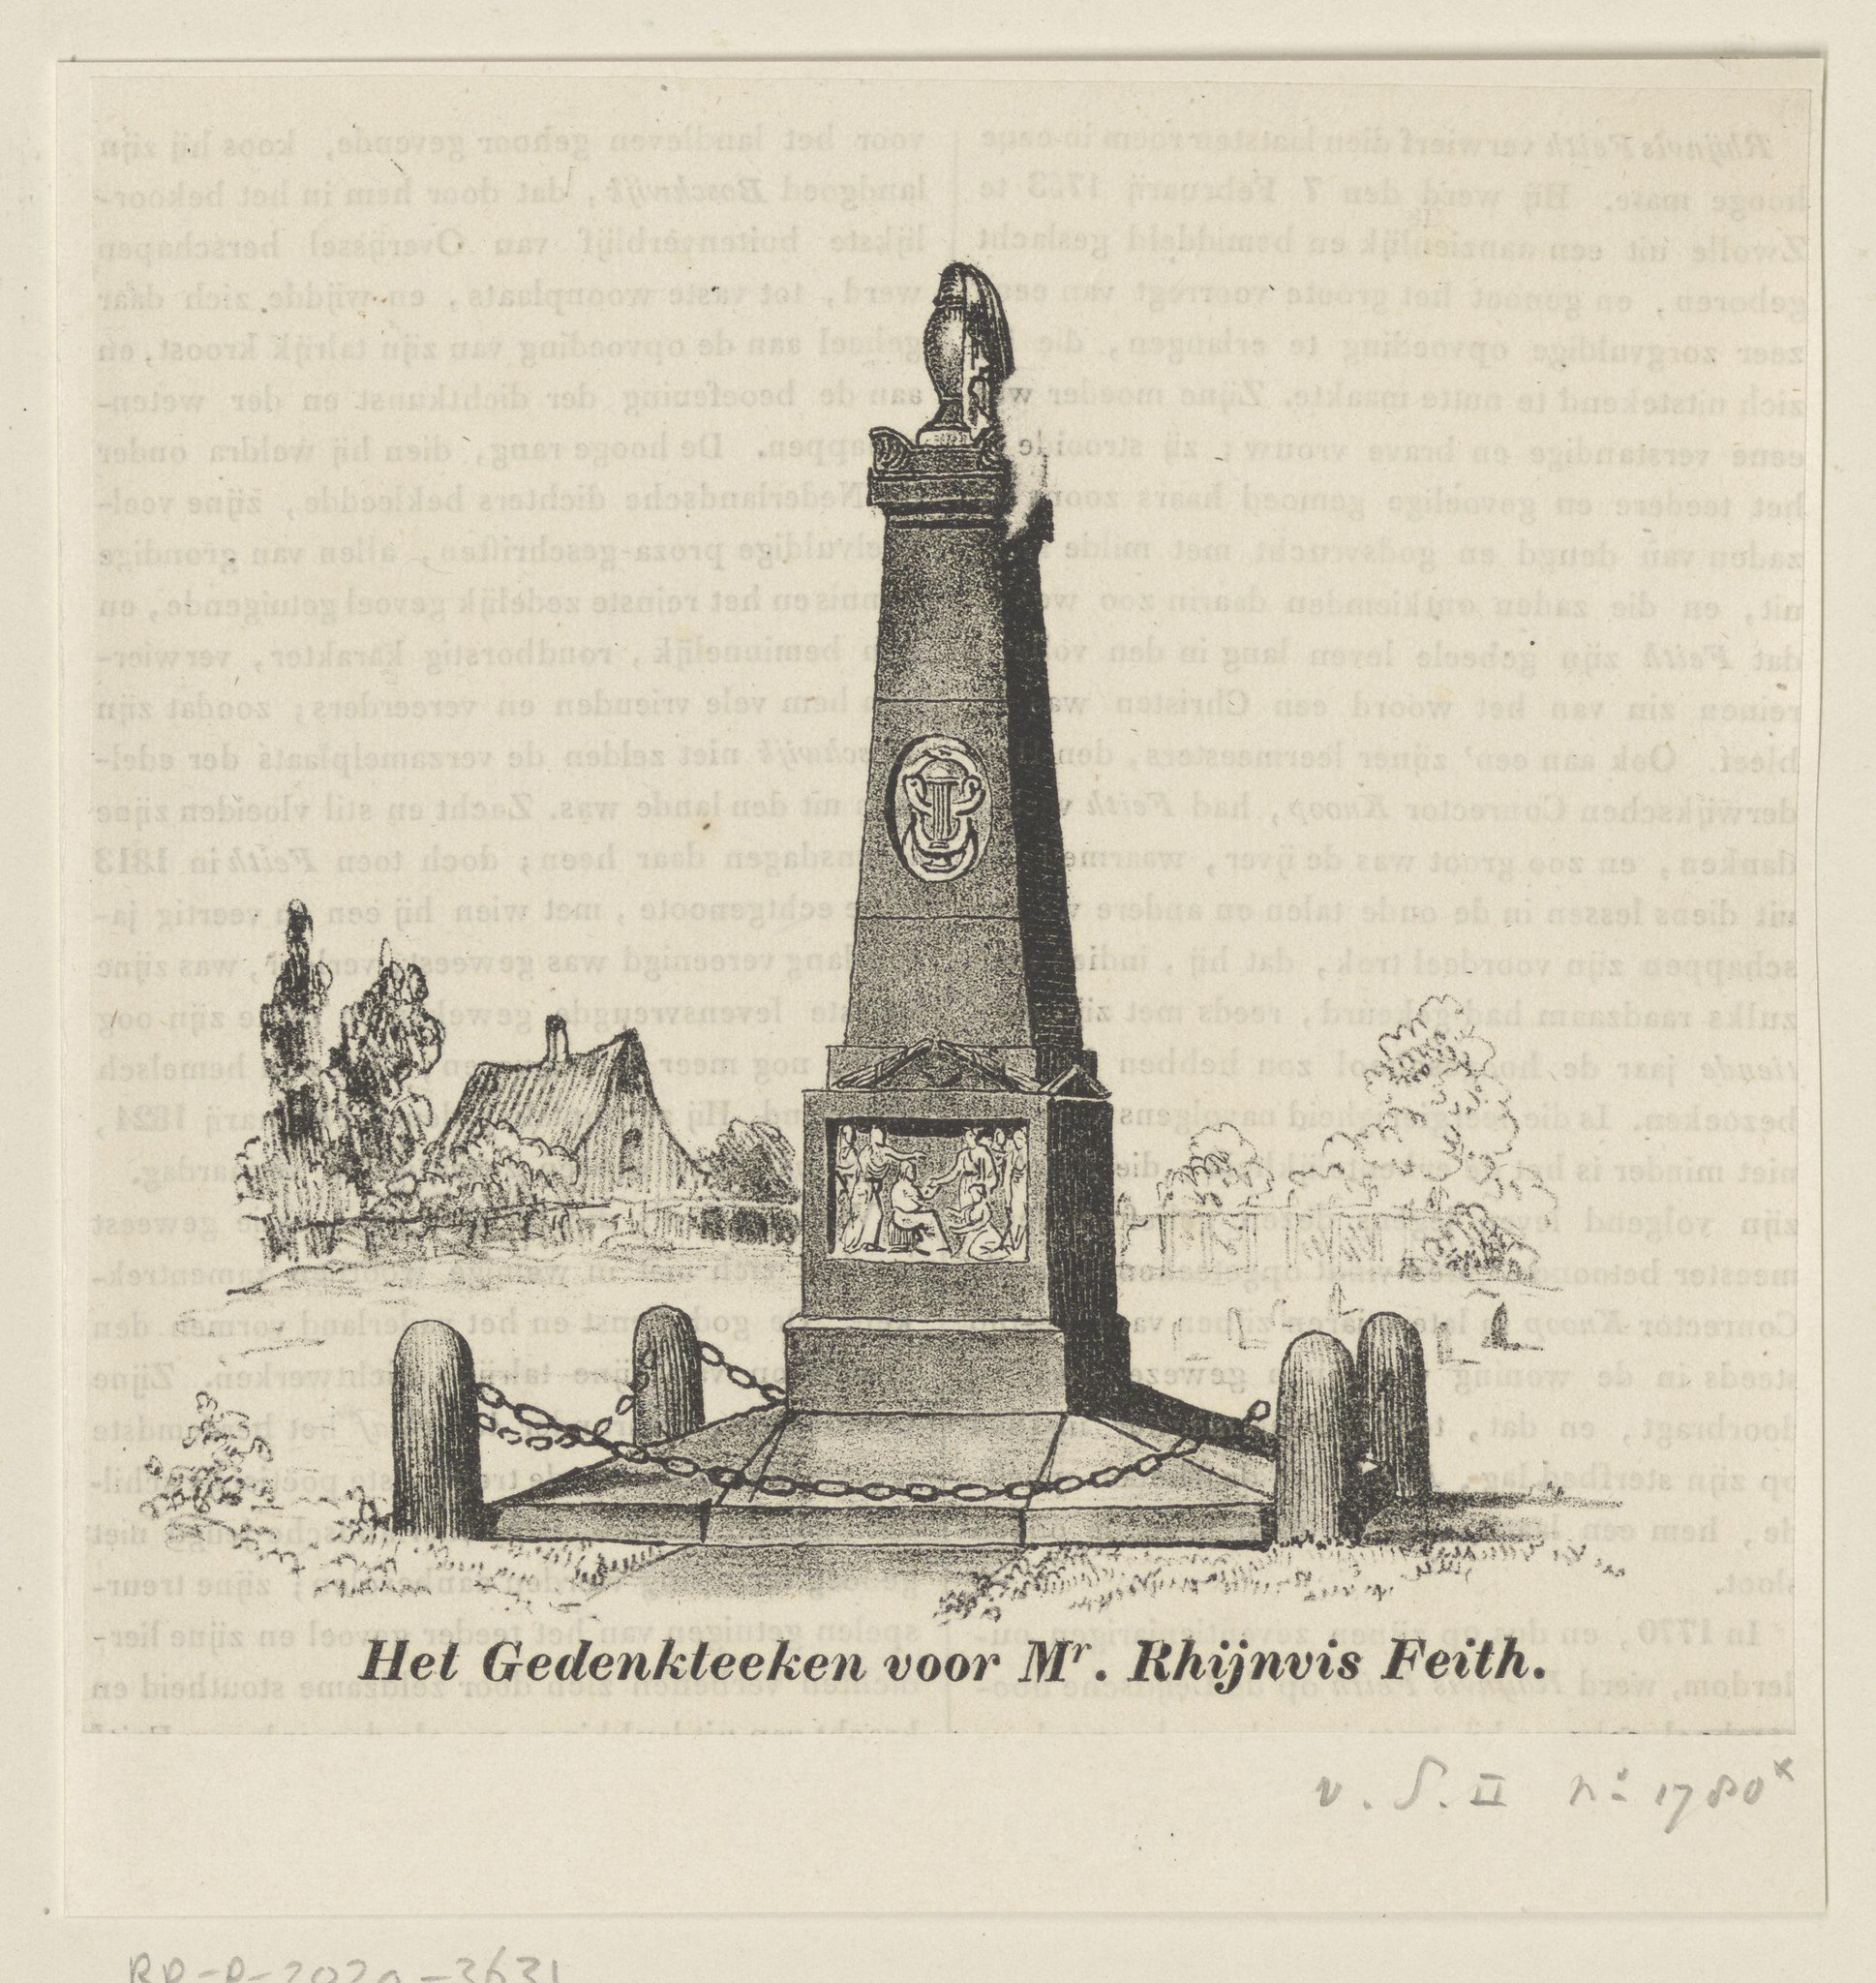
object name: print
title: Grafmonument voor Rhijnvis Feith op begraafplaats te Zwolle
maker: Anonymous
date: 1824-1850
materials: paper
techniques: letterpress printing, lithograph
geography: netherlands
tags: rhijnvis feith, historical persons, grave-building, monumental tomb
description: Prent komt uit een onbekende publicatie.